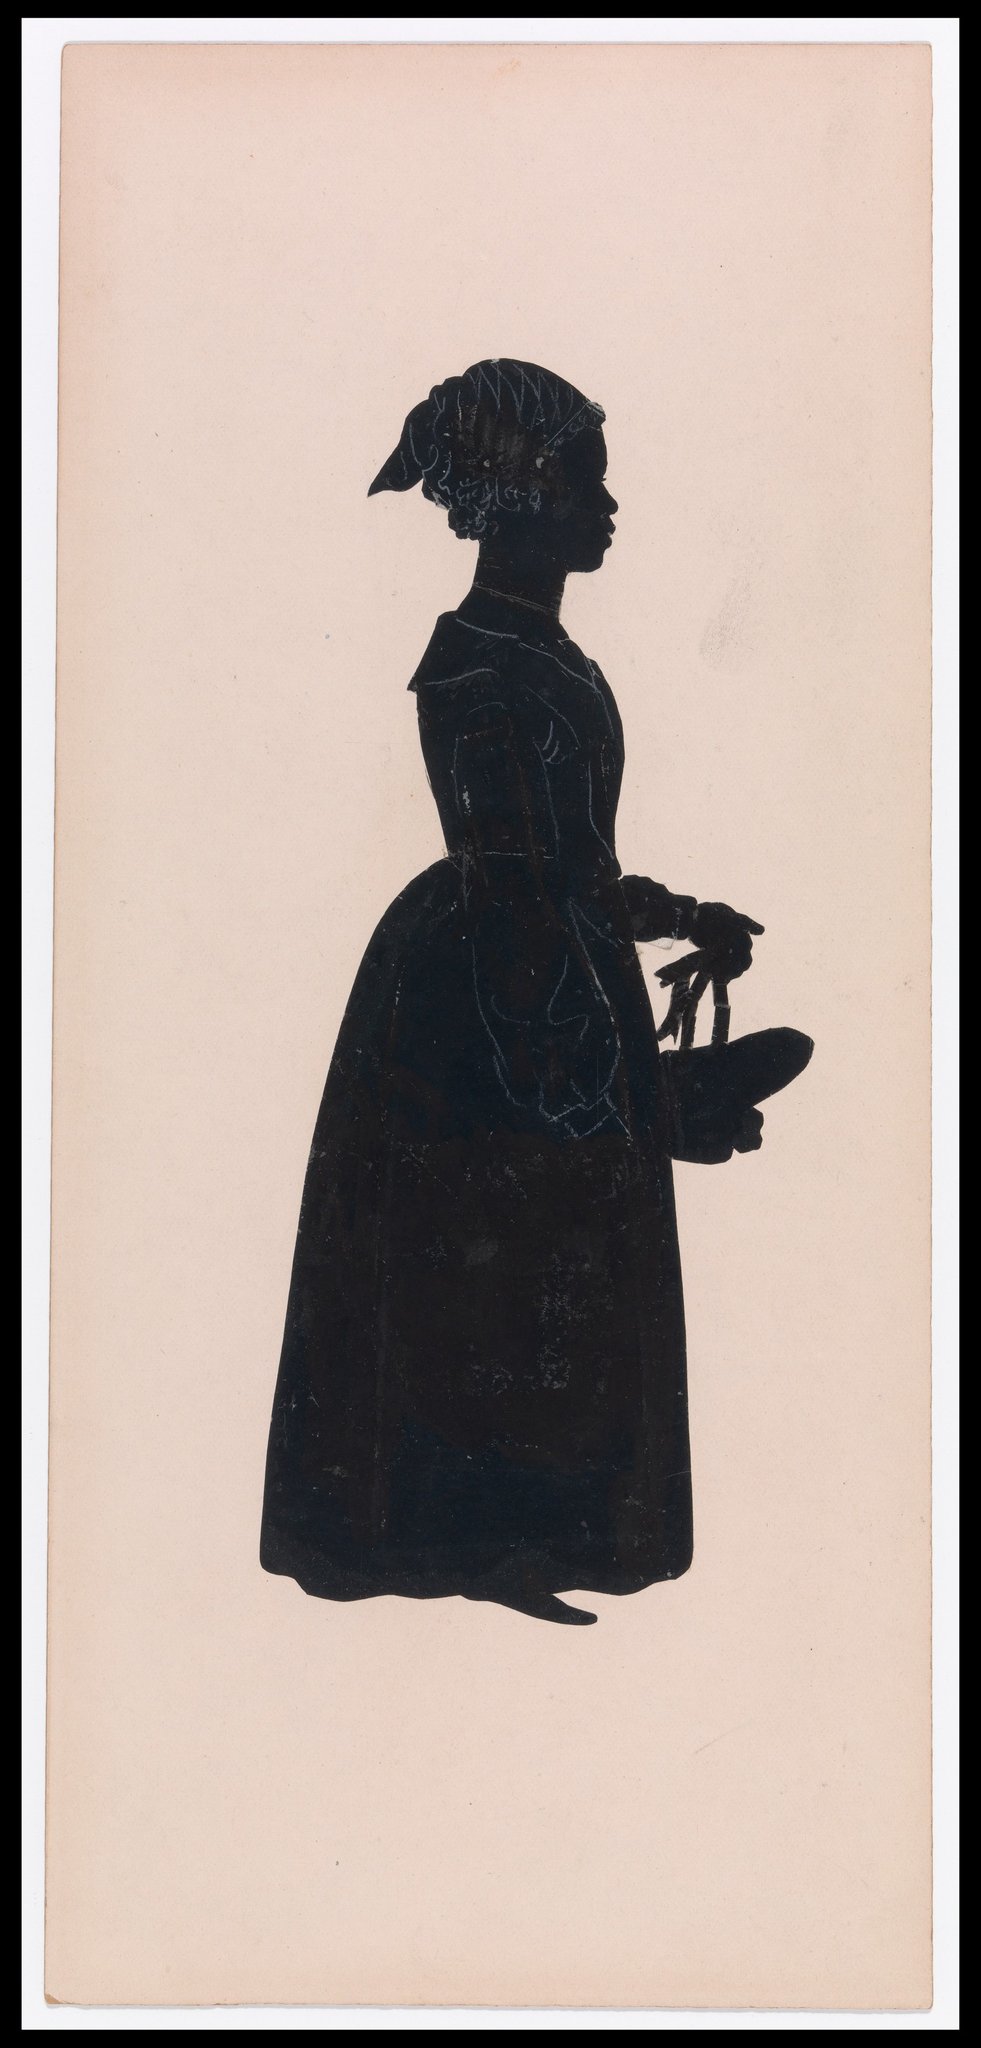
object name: cut paper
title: Dalmany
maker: auguste edouart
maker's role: artist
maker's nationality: french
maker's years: 1789-1861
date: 1844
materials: board, chalk, paper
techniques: cutting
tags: women